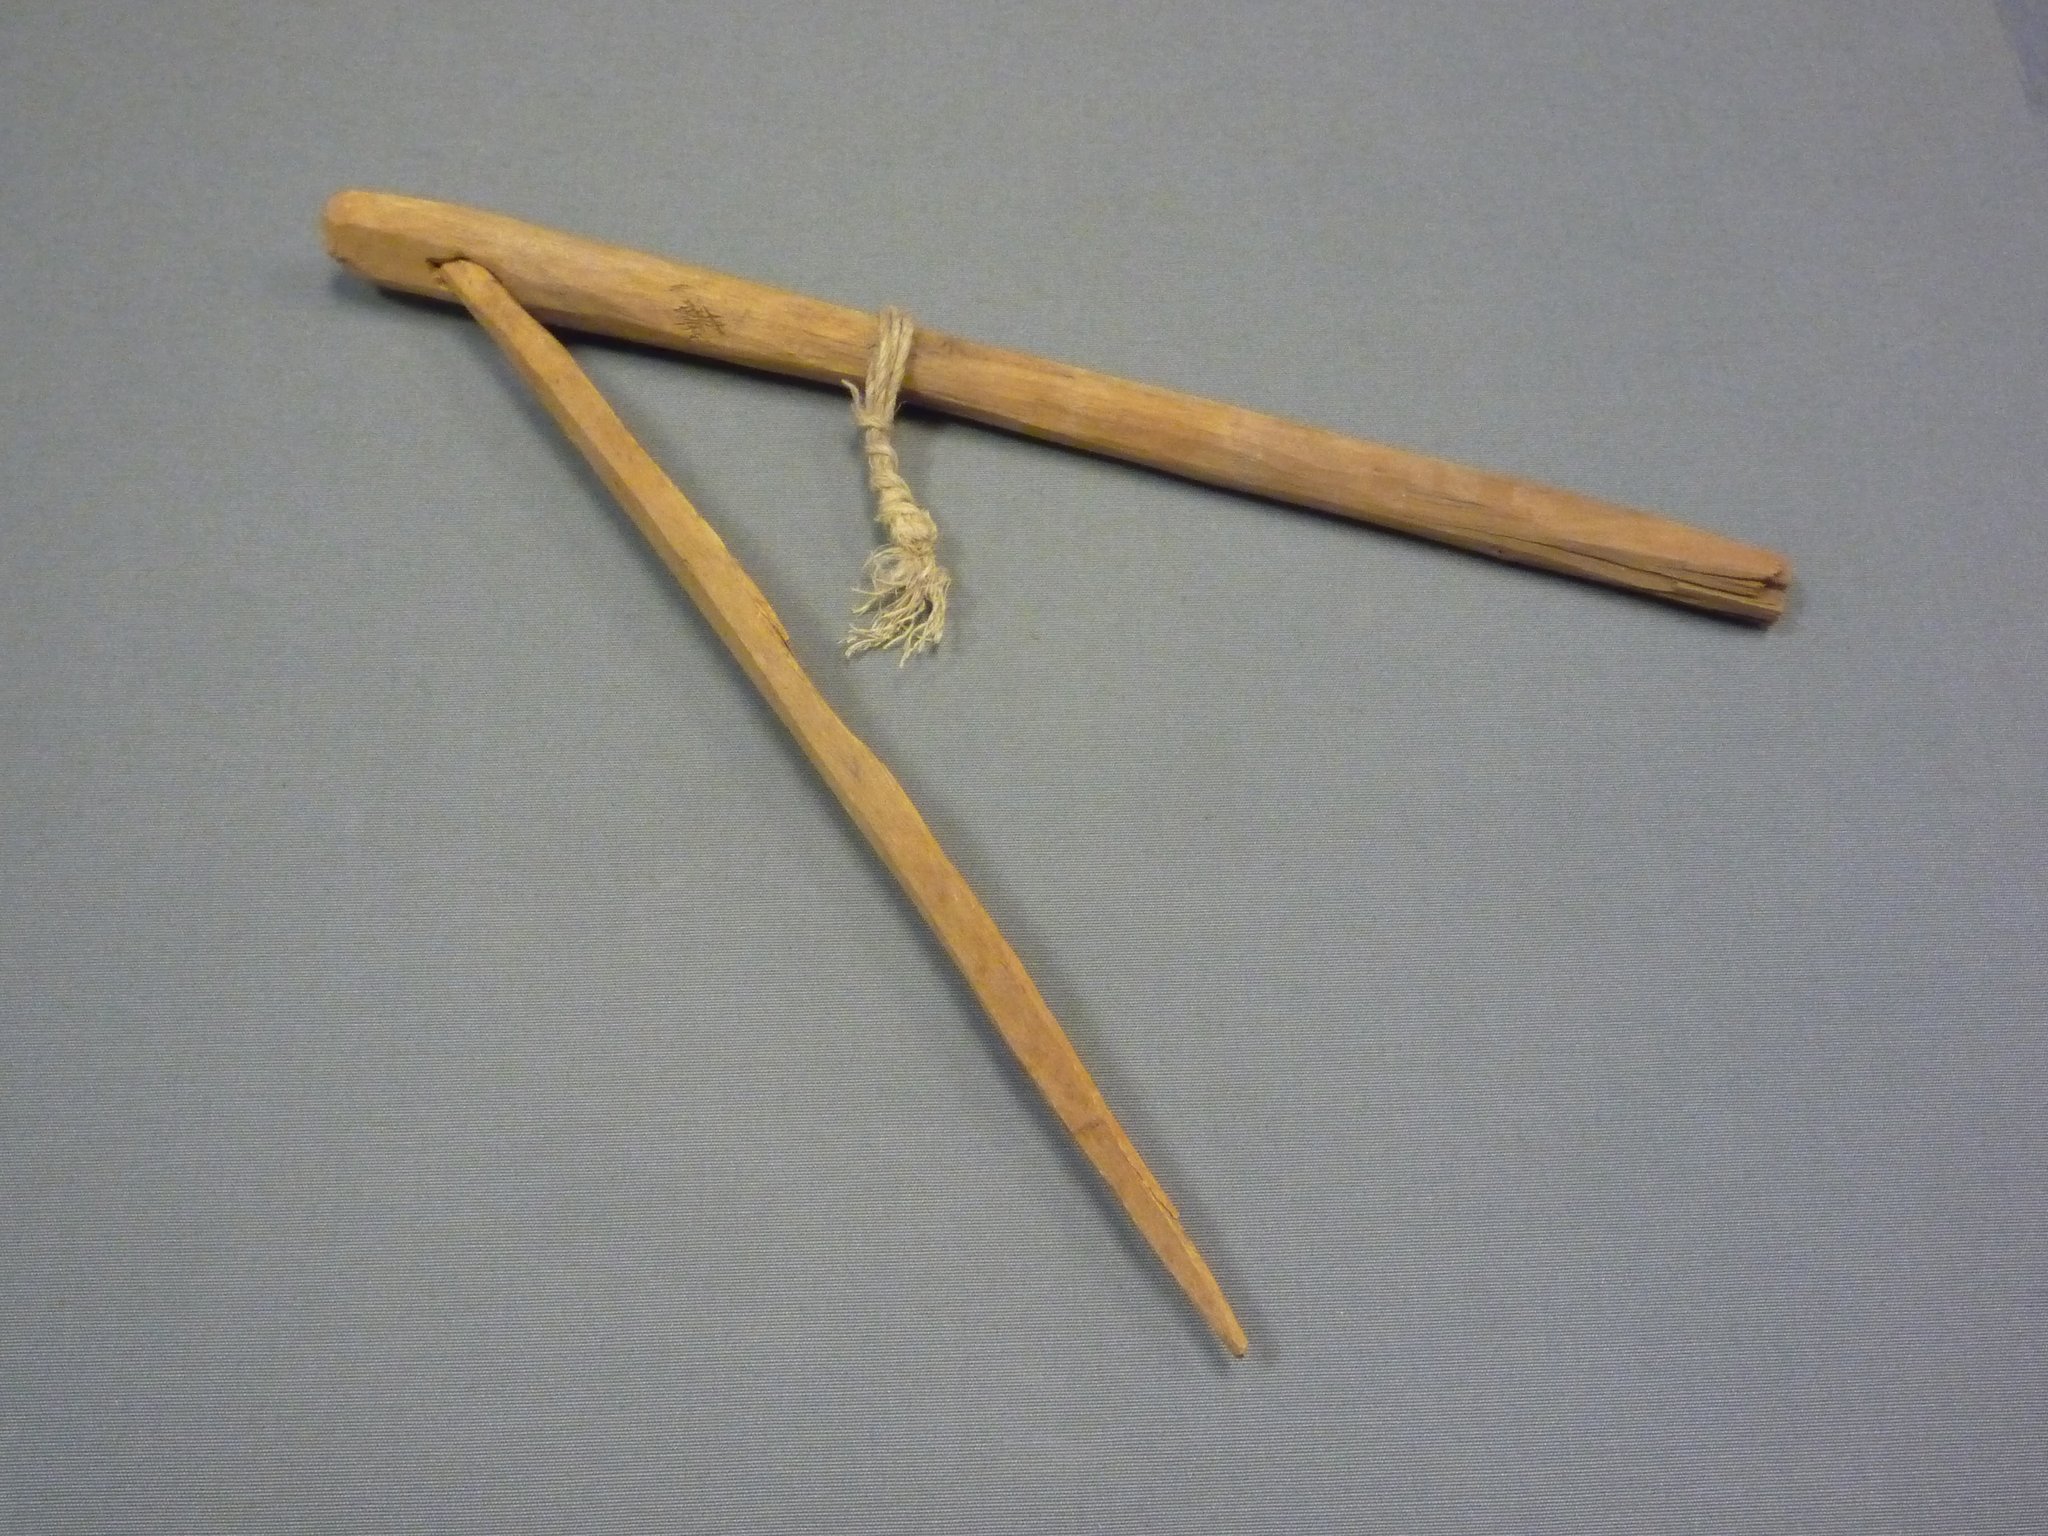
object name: model pick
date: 1479-1458 BCE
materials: linen, wood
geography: egypt